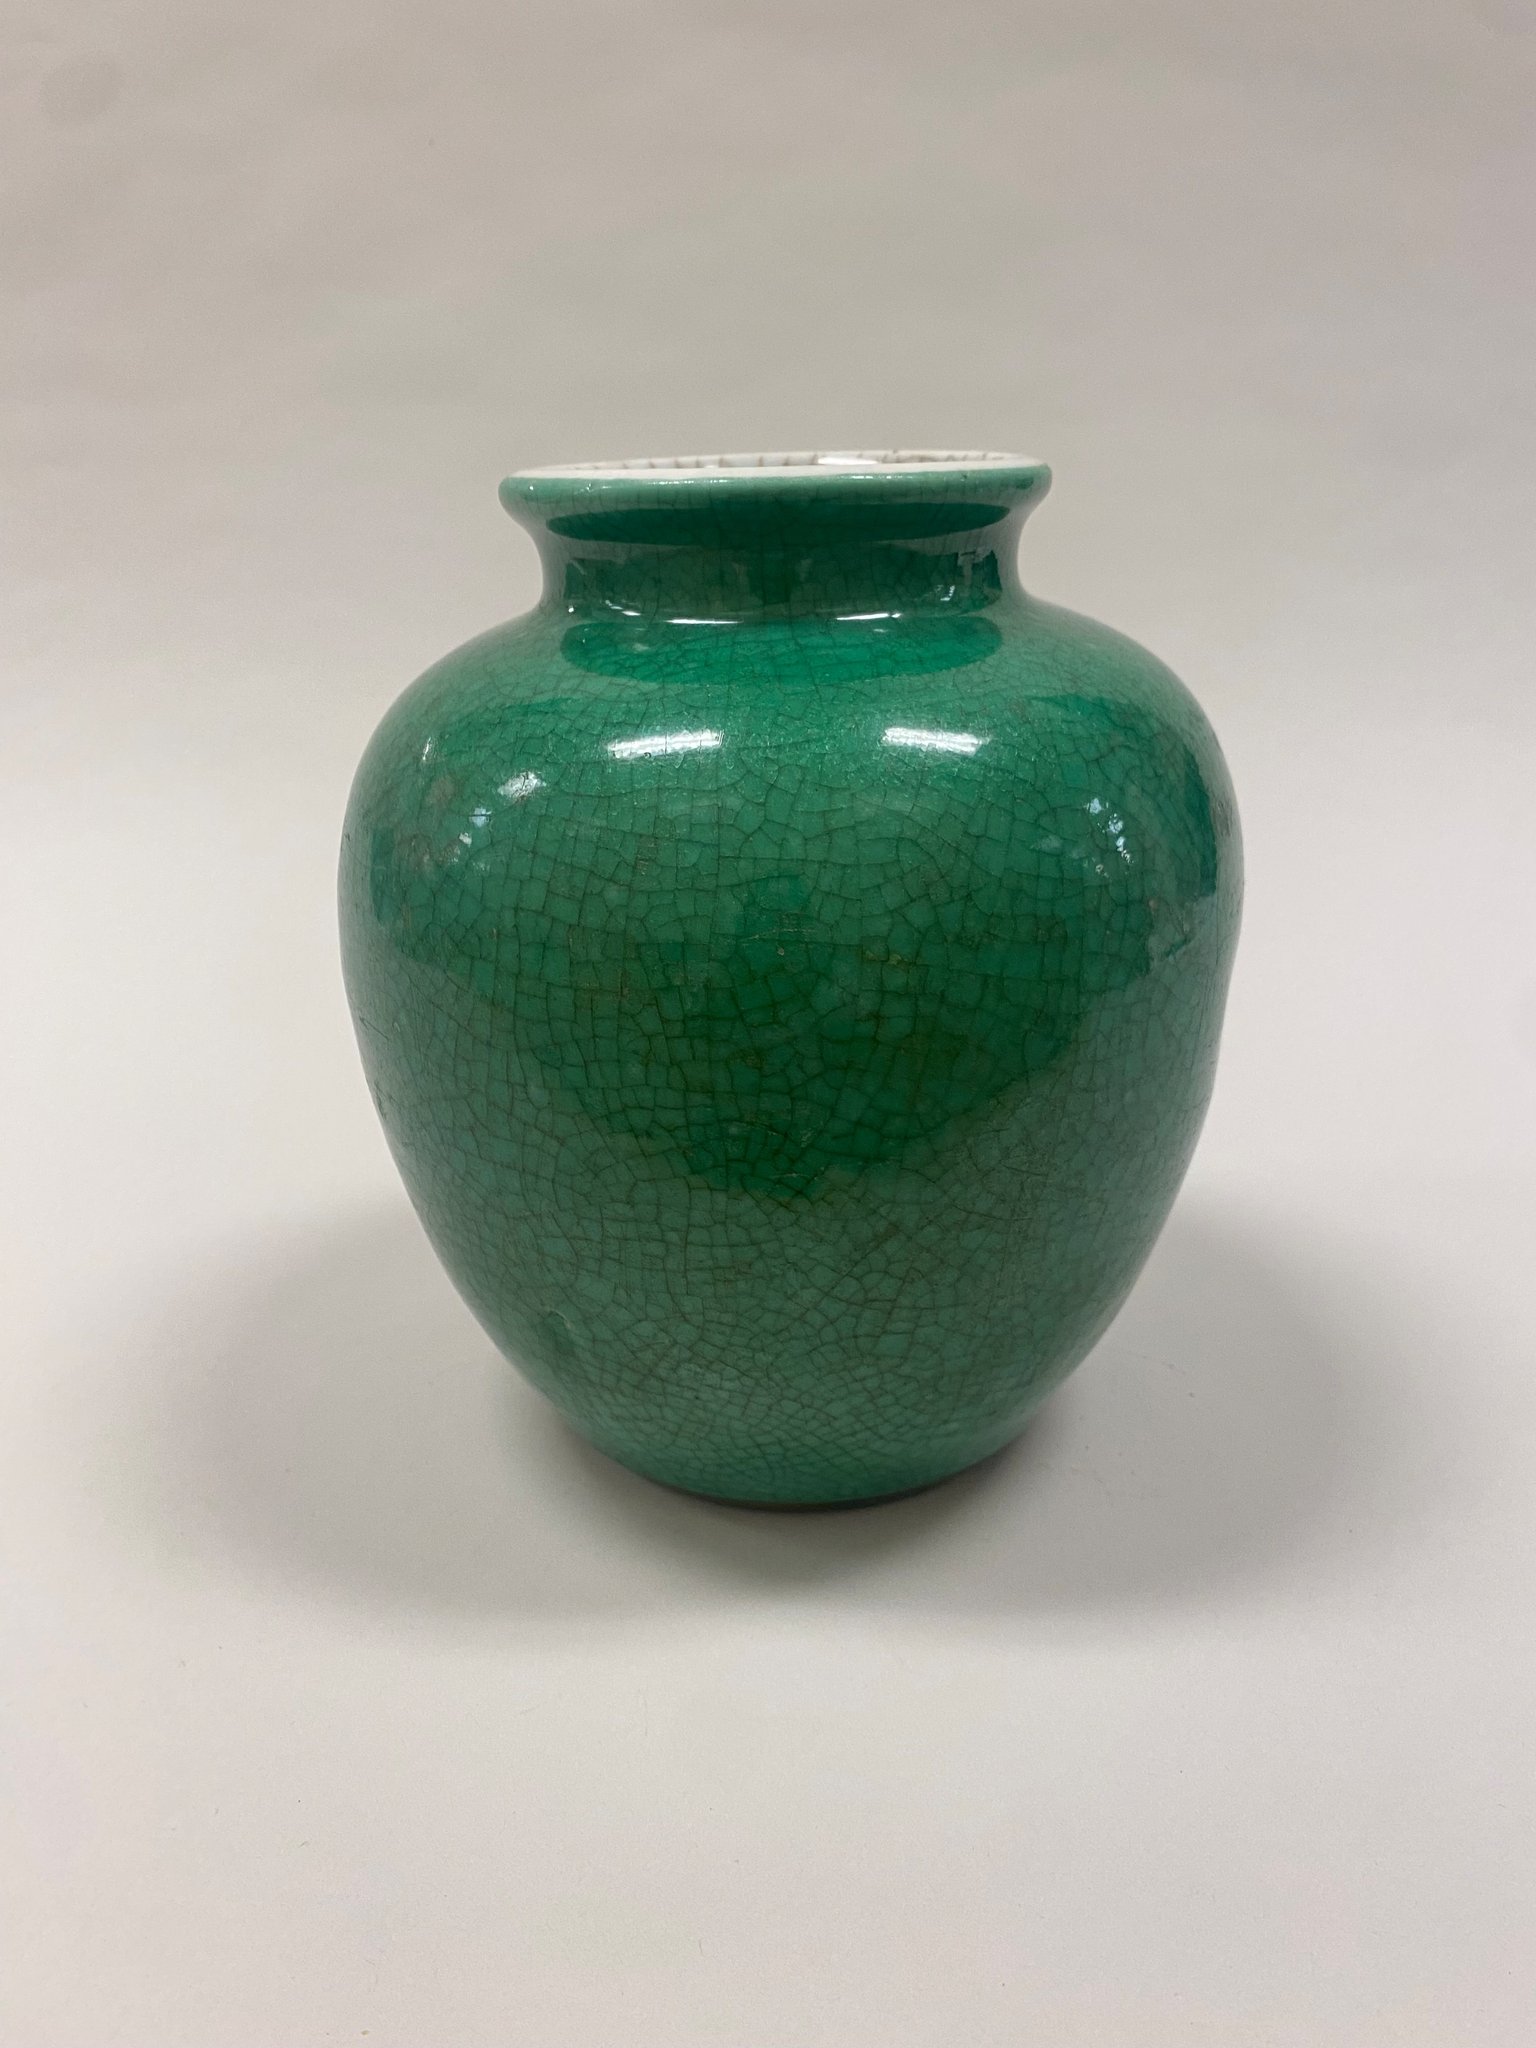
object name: jar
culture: chinese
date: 1701-1800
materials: glaze, porcelain